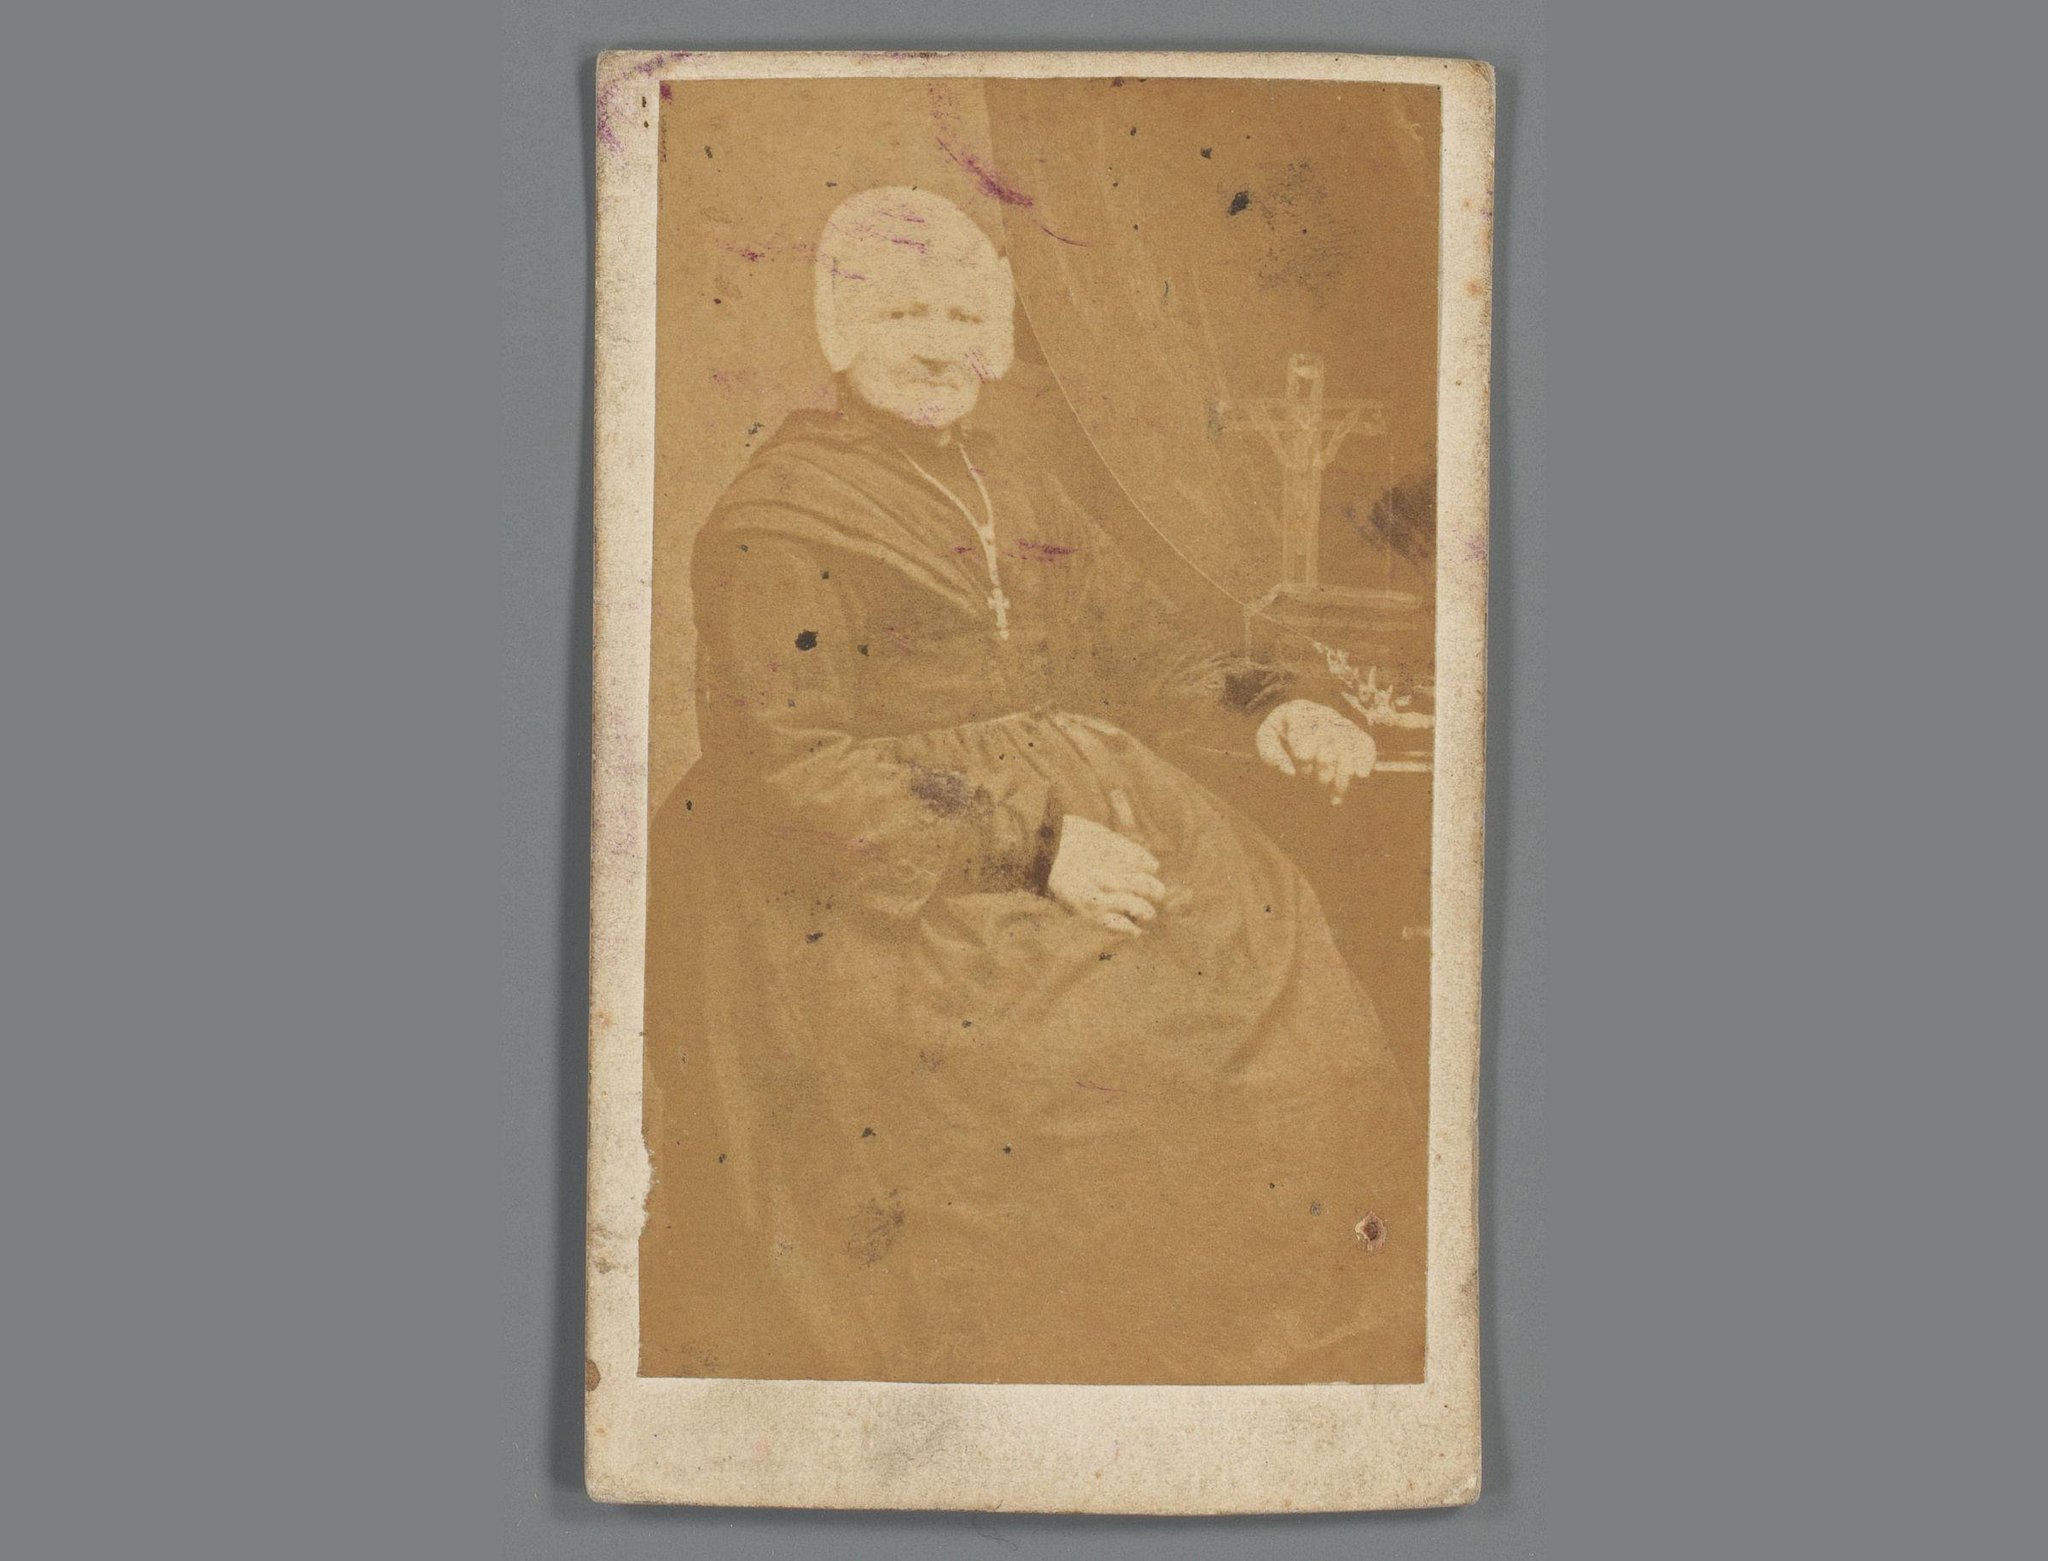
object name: photograph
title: Portret van Alida van Vliet op bidprent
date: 1868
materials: cardboard, paper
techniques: albumen print, letterpress printing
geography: hoenkoop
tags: historical persons, old woman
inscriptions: inscription: ‘Bid voor de ziel van zaliger/ Alida van Vliet, (...) eeuwige rust./ Rotterdam.- P.T. Braam.’